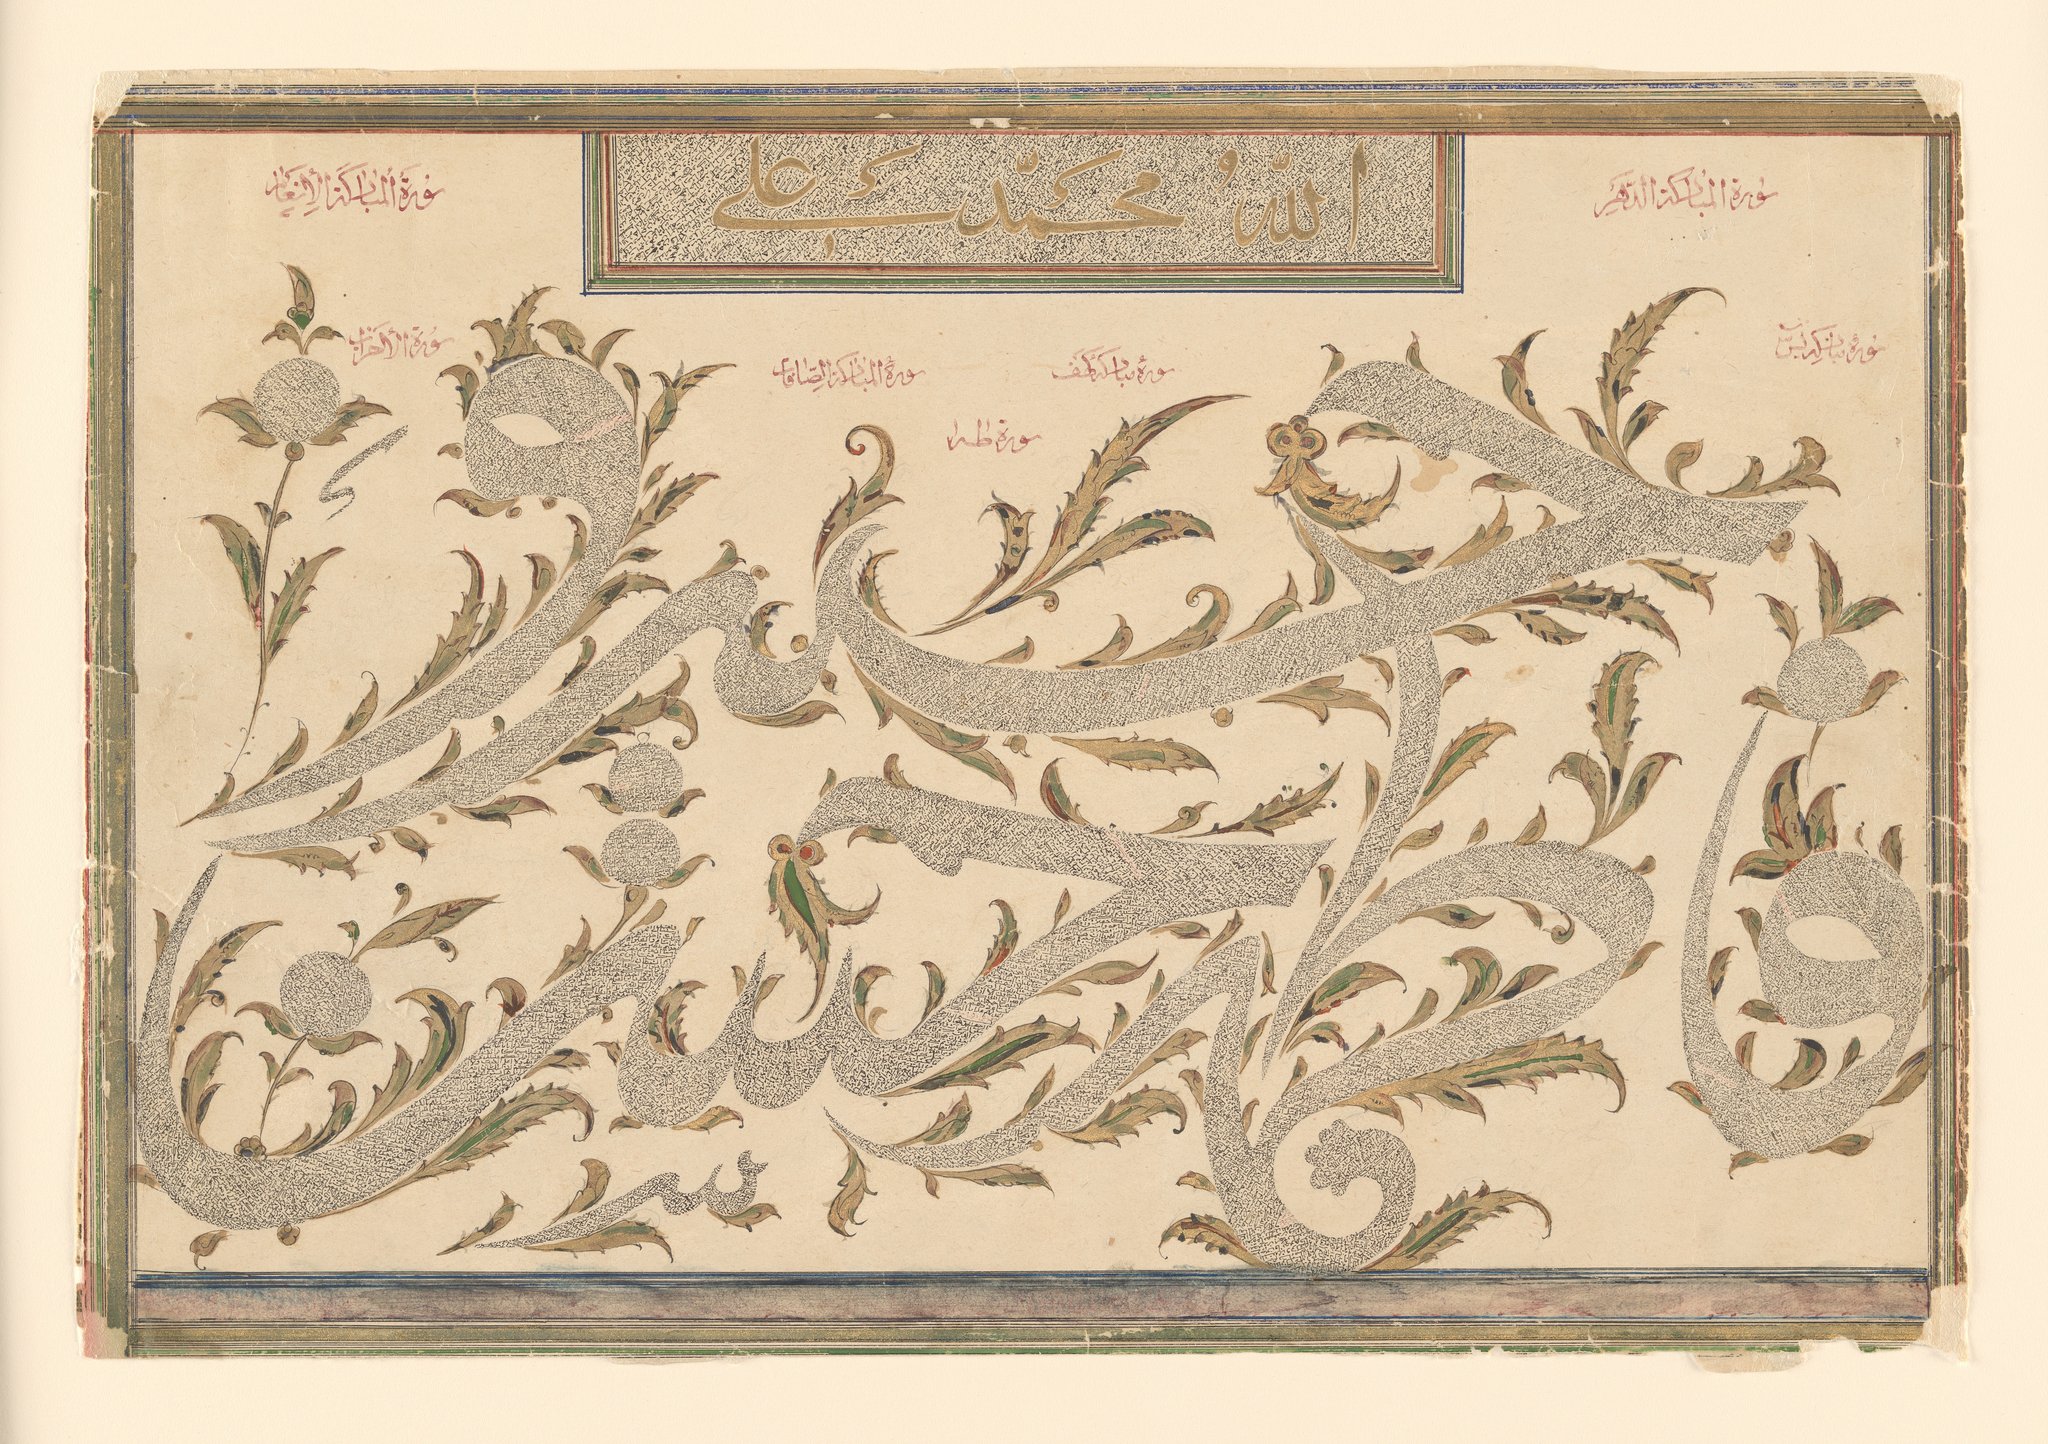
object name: non illustrated album leaf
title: Calligraphic Composition in Ghubari Script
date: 1851-1900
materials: gold, ink, paper, watercolor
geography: iran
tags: calligraphy